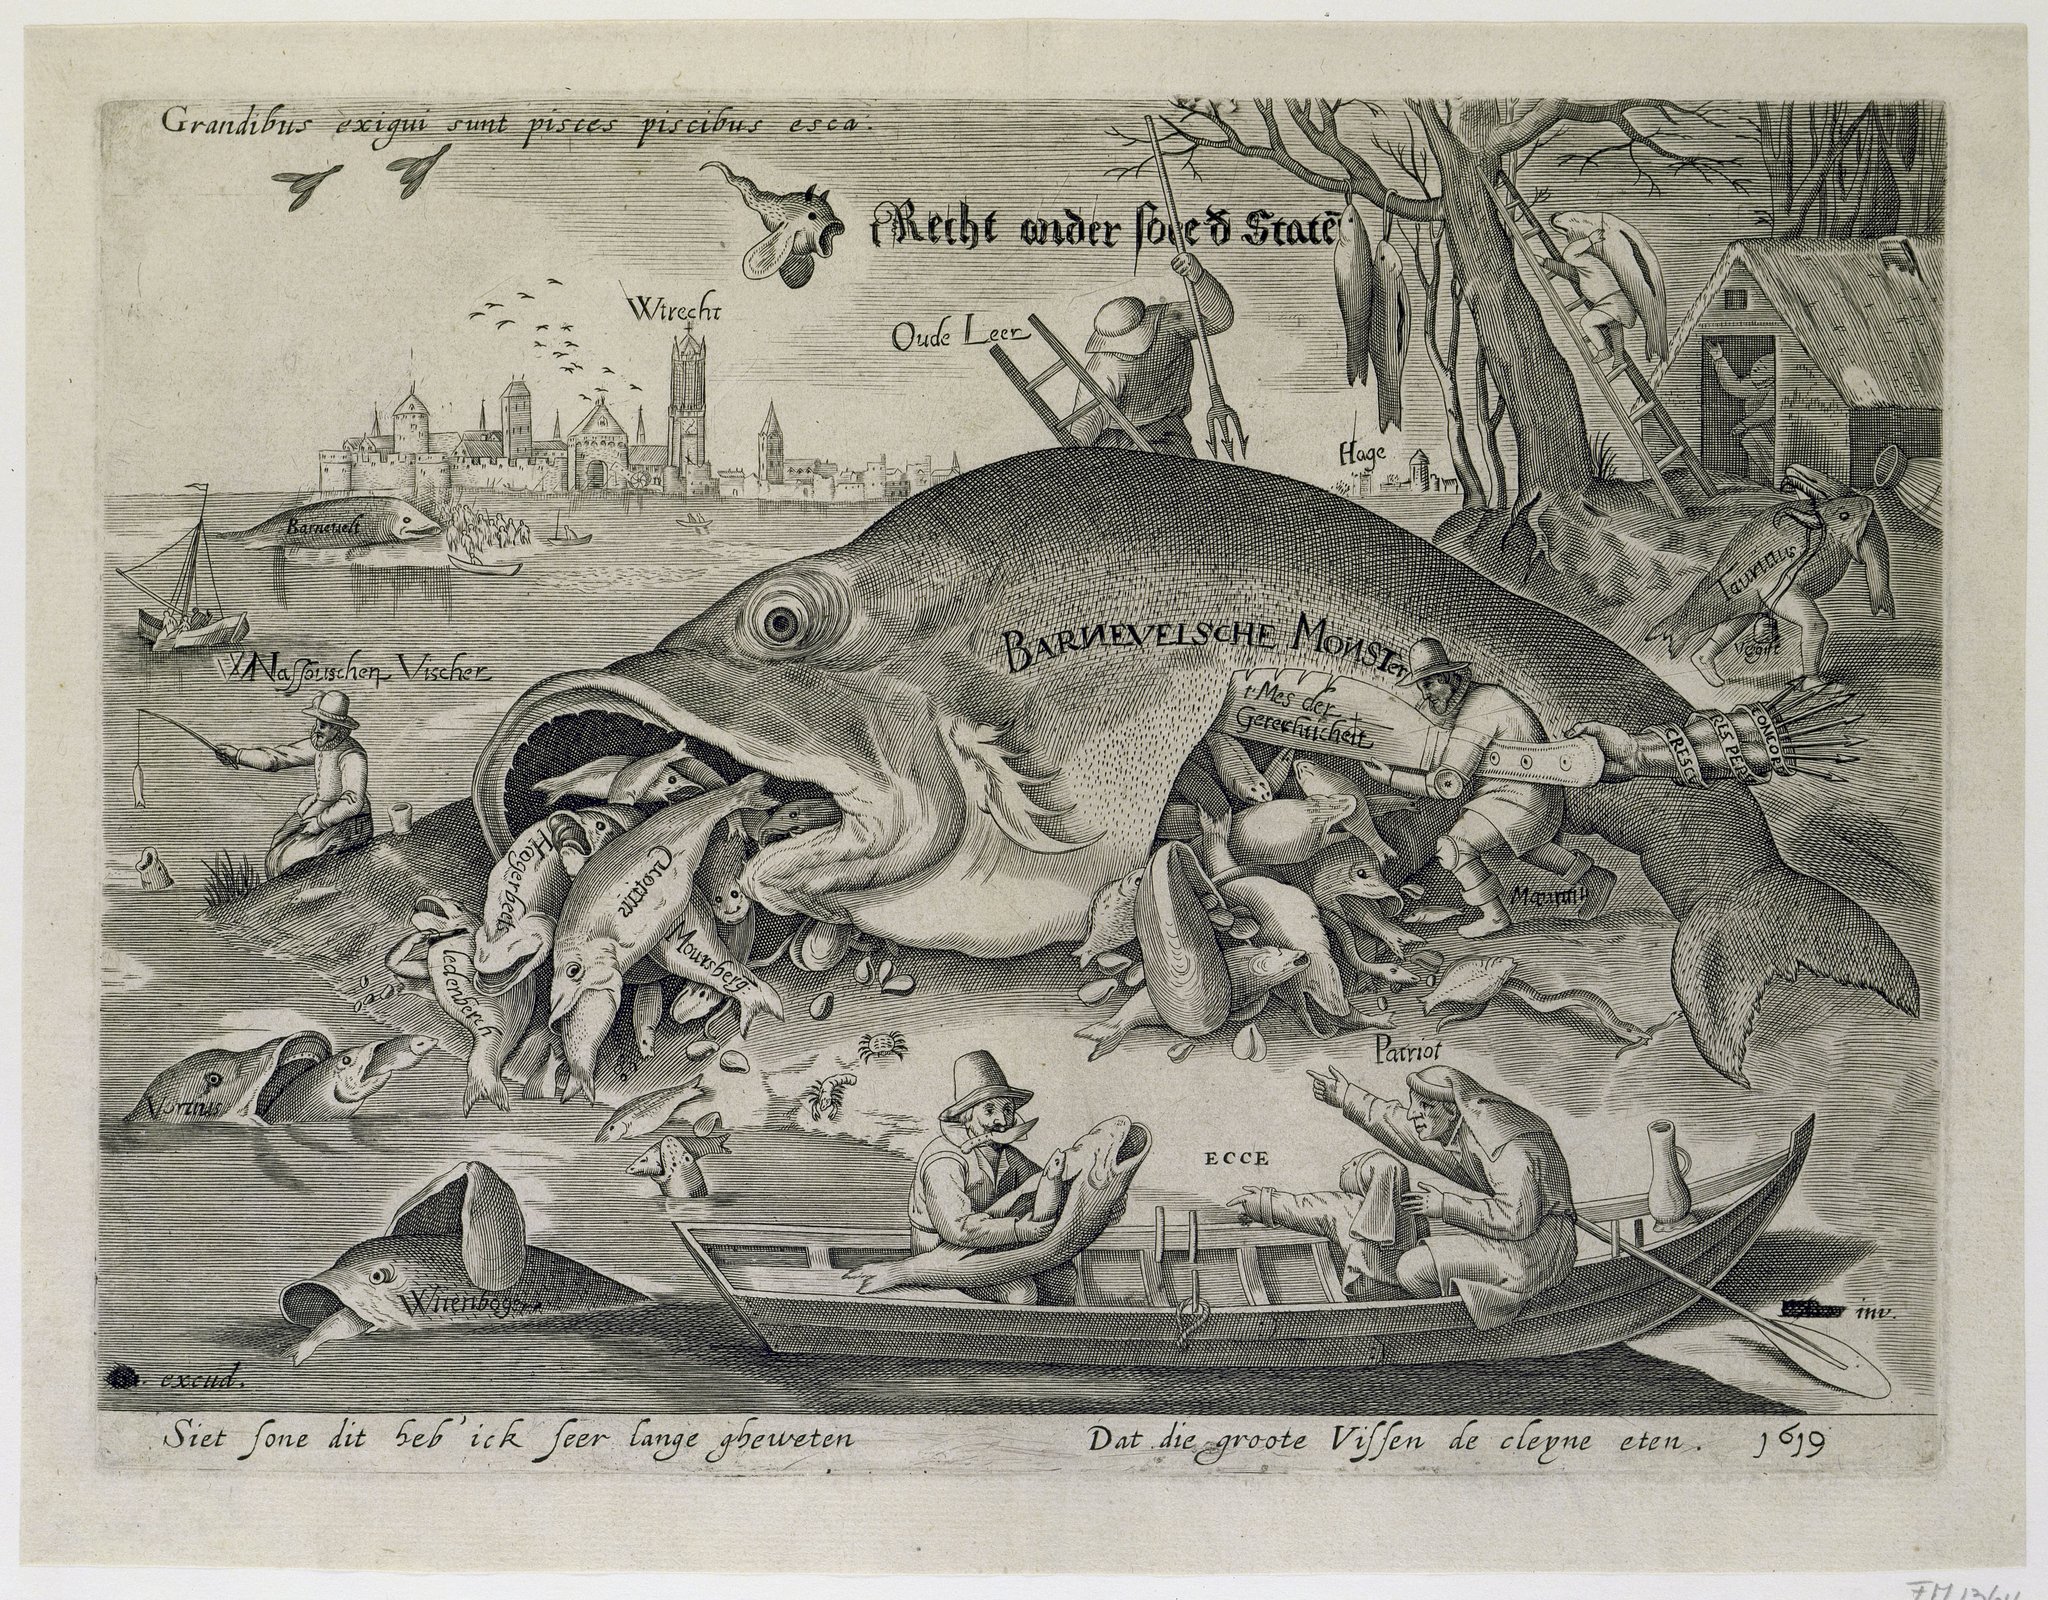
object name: cartoon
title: De grote vissen eten de kleine vissen, spotprent op de val van Johan van Oldenbarnevelt, 1619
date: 1619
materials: paper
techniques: engraving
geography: northern netherlands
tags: delft, hugo de groot, johan van oldenbarnevelt, the hague, maurice (prince of orange), antwerp, utrecht, cologne, hoorn (north holland), fabulous animals ~ fishes, fishes, proverbs, sayings, etc., angling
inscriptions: date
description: Spotprent op de val van Johan van Oldenbarnevelt en de remonstranten, 1619. Verbeelding van het spreekwoord 'de grote vissen eten de kleine'. Prins Maurits snijdt met het Mes der Gerechtigheid een grote vis 'Barnevelsche Monster' open. In de bek van de vis en in het water bevinden zich andere kleine vissen met namen van de bekendste remonstranten. Op de voorgrond wijst een vader naar het tafereel en leert zijn zoon 'Siet sone dit heb' ick seer lange gheweten / Dat die groote Vissen de cleyne eten'. Op de achtergrond liggen de steden Utrecht en 's-Gravenhage.